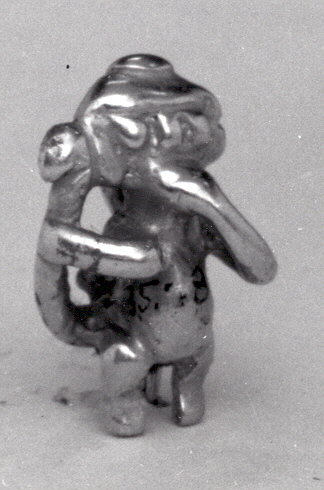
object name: monkey ornament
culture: costa rican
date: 901-1500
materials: gold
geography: costa rica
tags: monkeys